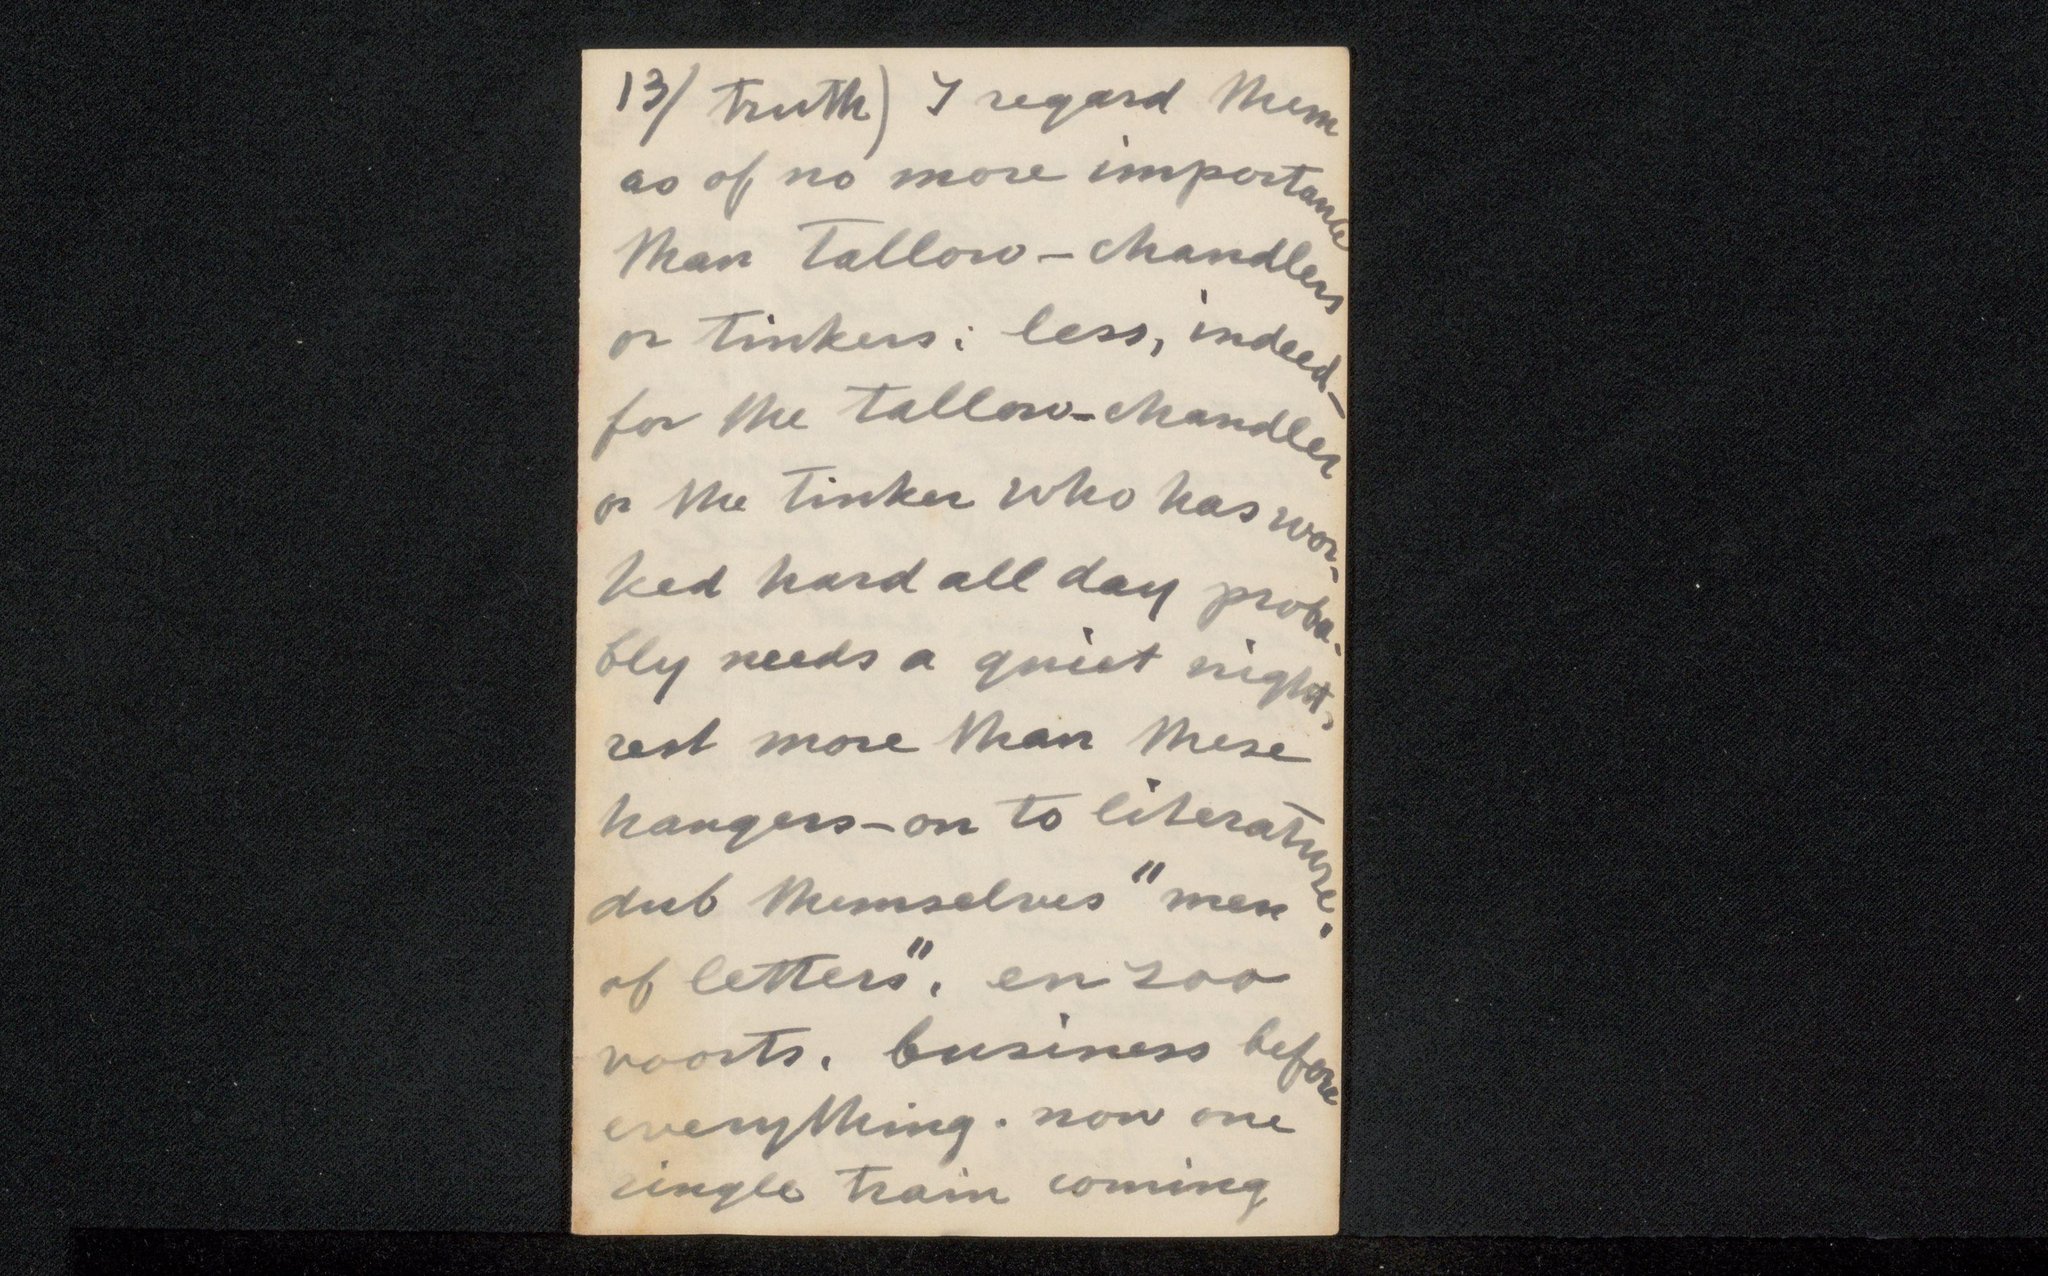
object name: letter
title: Brief aan Philip Zilcken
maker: matthijs maris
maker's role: draughtsman, painter, print maker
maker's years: 1839-1917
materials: ink, paper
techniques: pen, writing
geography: london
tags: philip zilcken, literature ~ arts, money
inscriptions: collector's mark: ‘RPK’, watermark